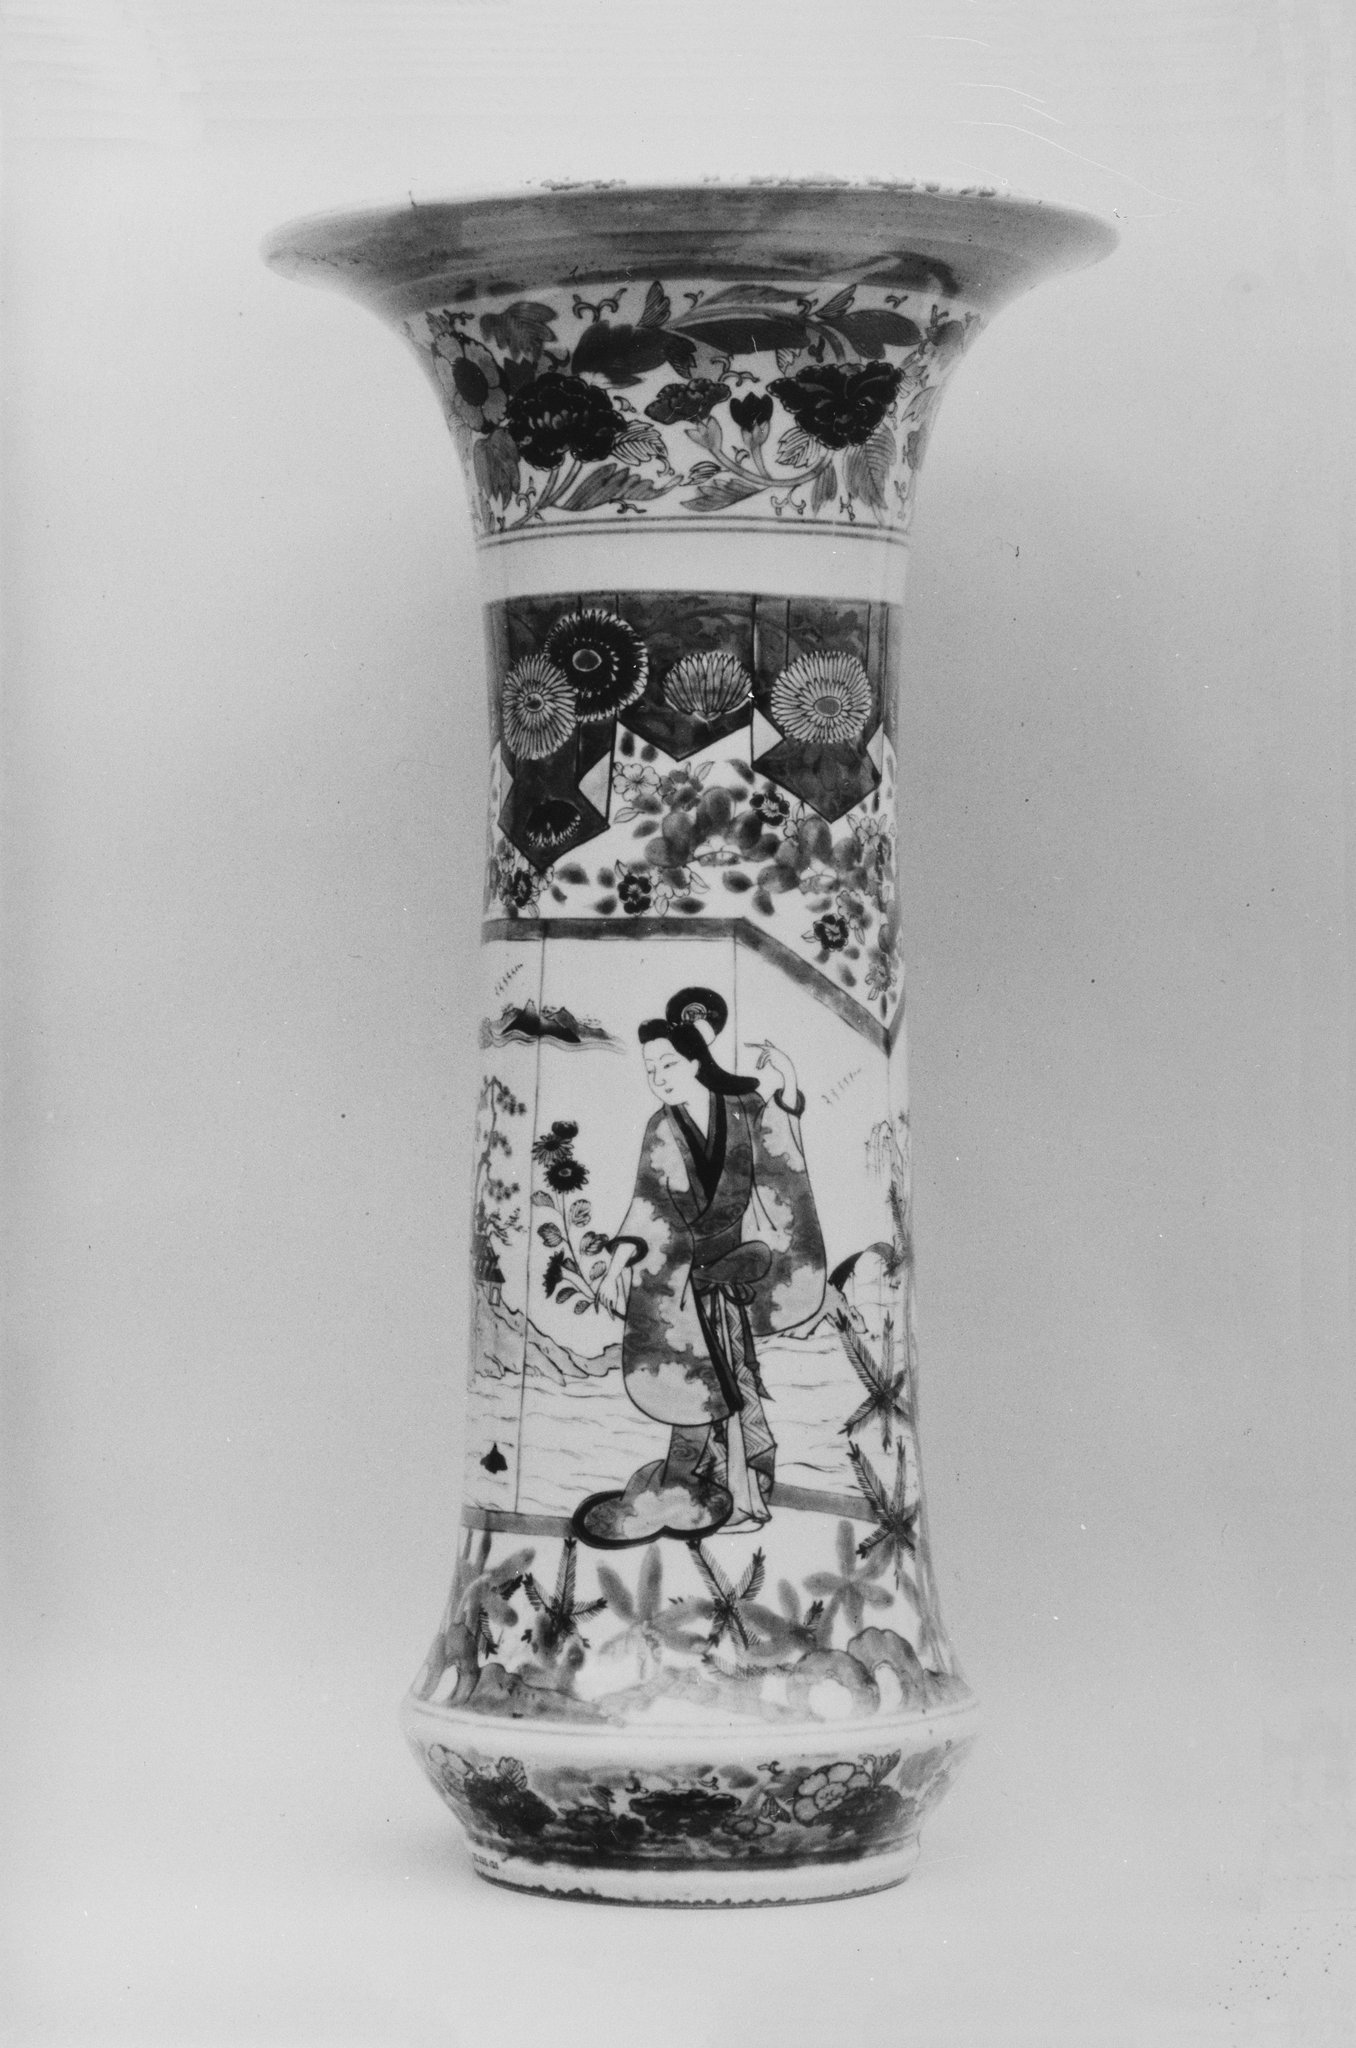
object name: vase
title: Vase with an Urban Beauty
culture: japanese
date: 1700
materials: enamel, porcelain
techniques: gilding, painting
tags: women,flowers